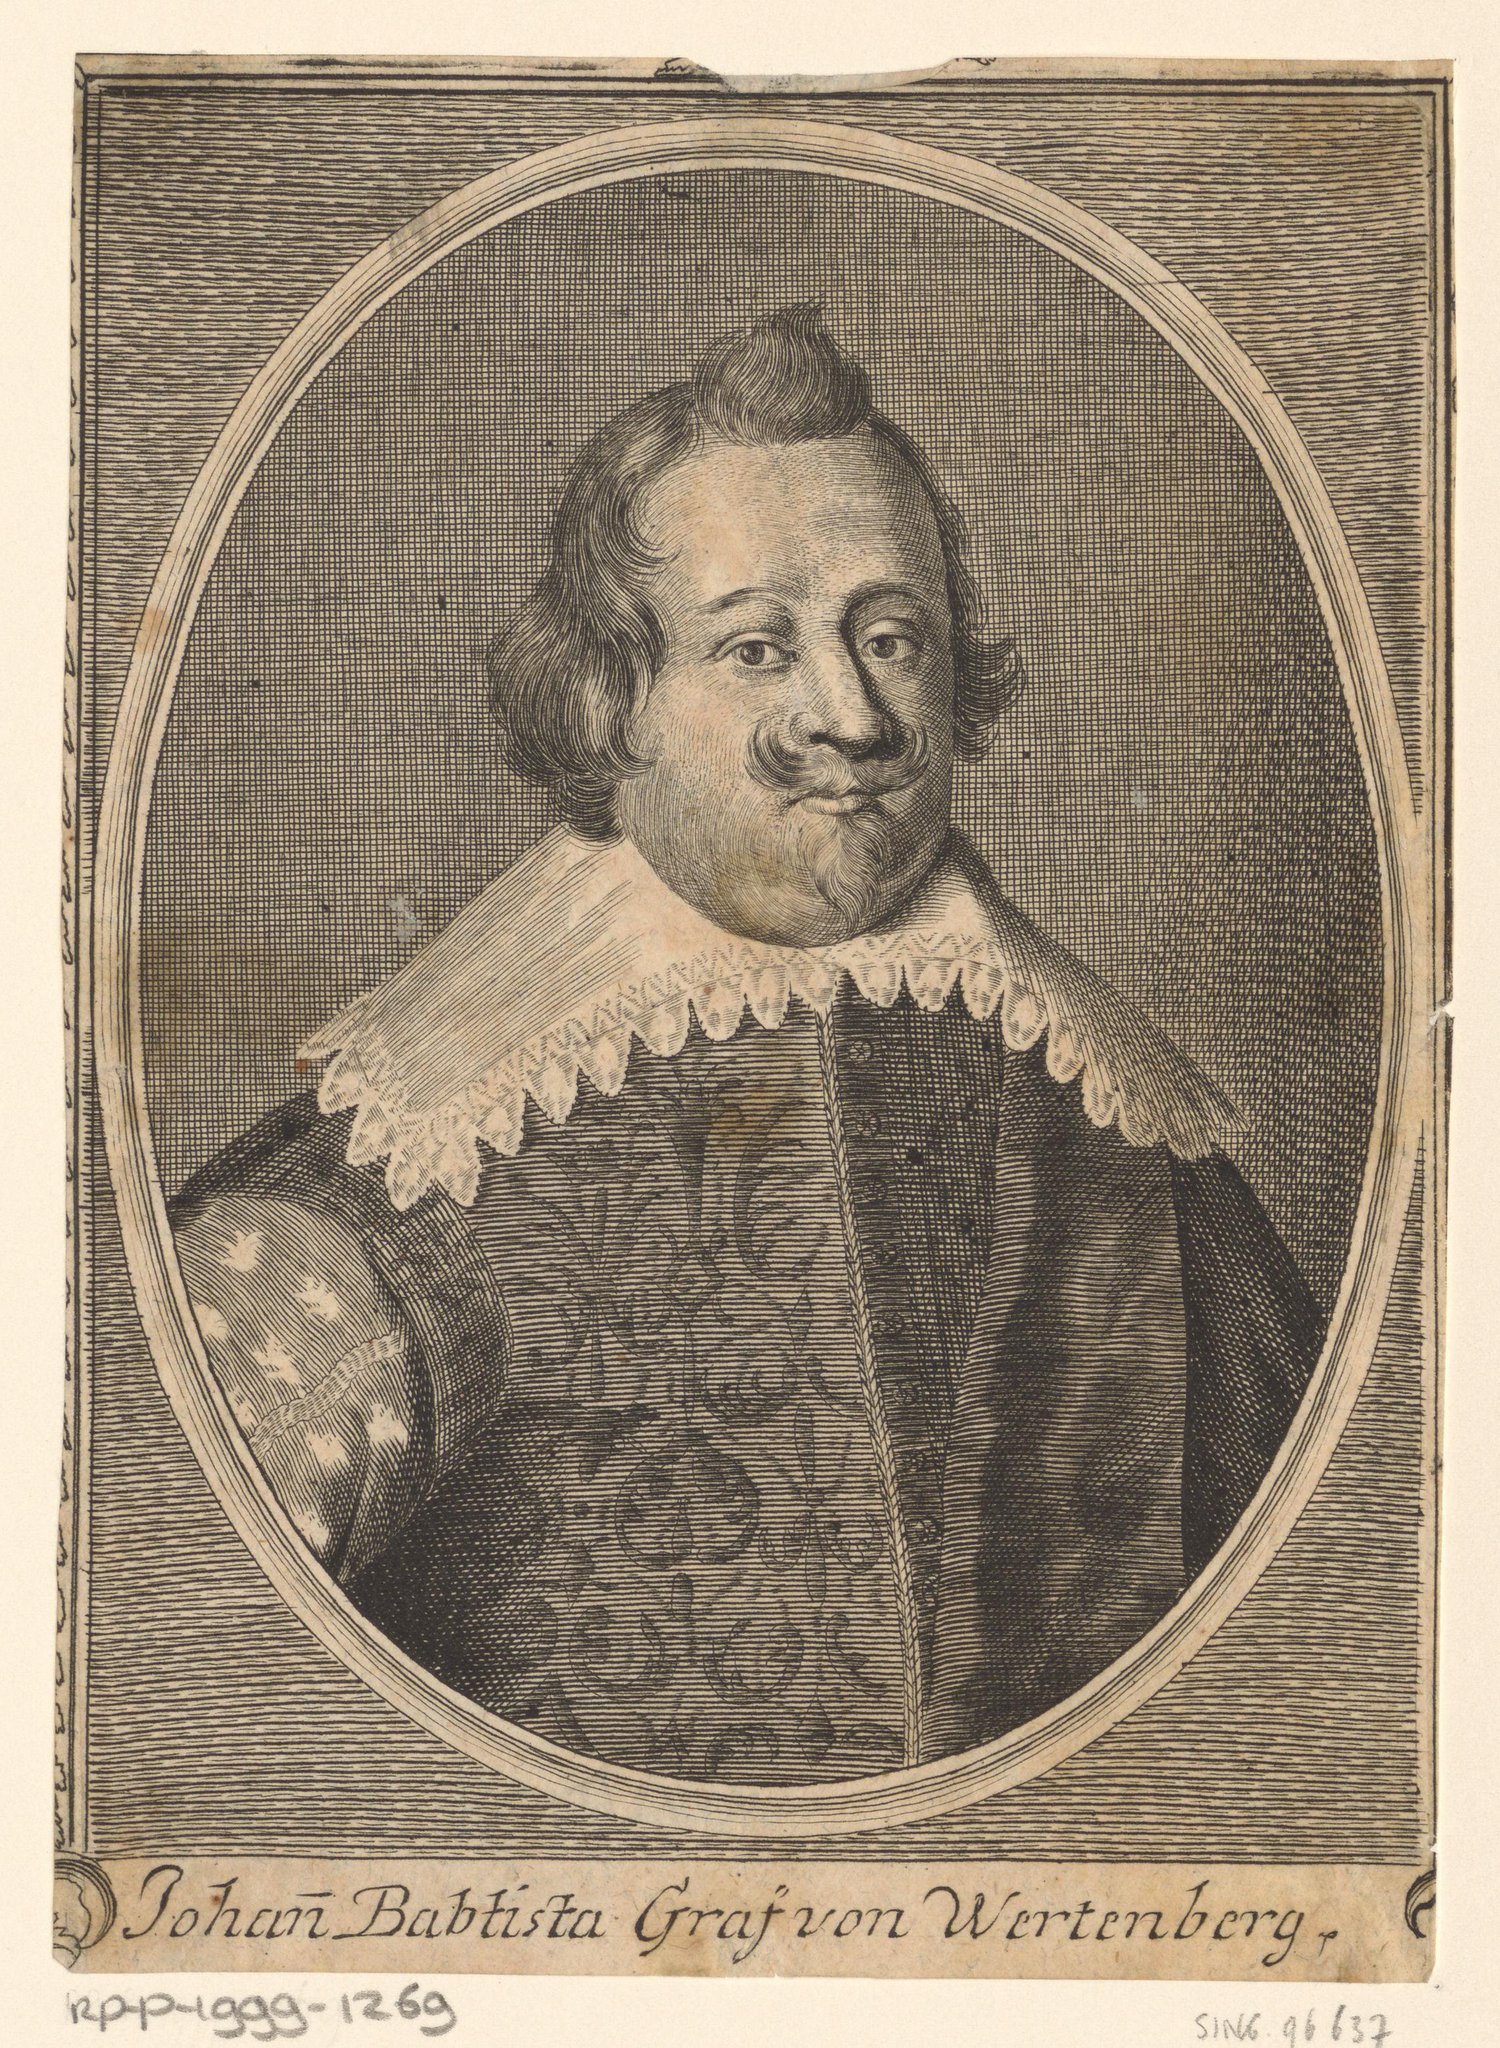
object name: print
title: Johan Babtista Graf von Wertenberg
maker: Anonymous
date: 1722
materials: paper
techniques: engraving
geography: germany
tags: historical persons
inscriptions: inscription: ‘Portr. 55169’, collector's mark: Lugt 2760, collector's mark: Lugt 2228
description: Prent waarschijnlijk uit: Khevenhüller, Franz Christoph. Conterfet Kupfferstich (...). Leipzig: Moritz Georg Weidmann, 1722, dl. 2.